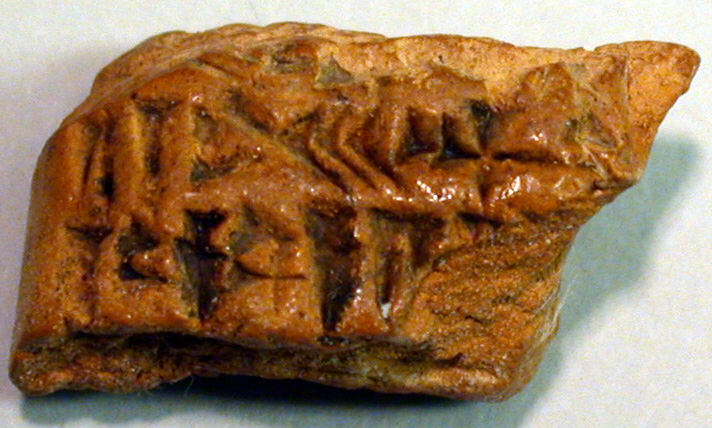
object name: cuneiform tablet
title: Cuneiform tablet: fragment, Ebabbar archive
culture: achaemenid or babylonian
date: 700-301 BCE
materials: clay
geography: mesopotamia